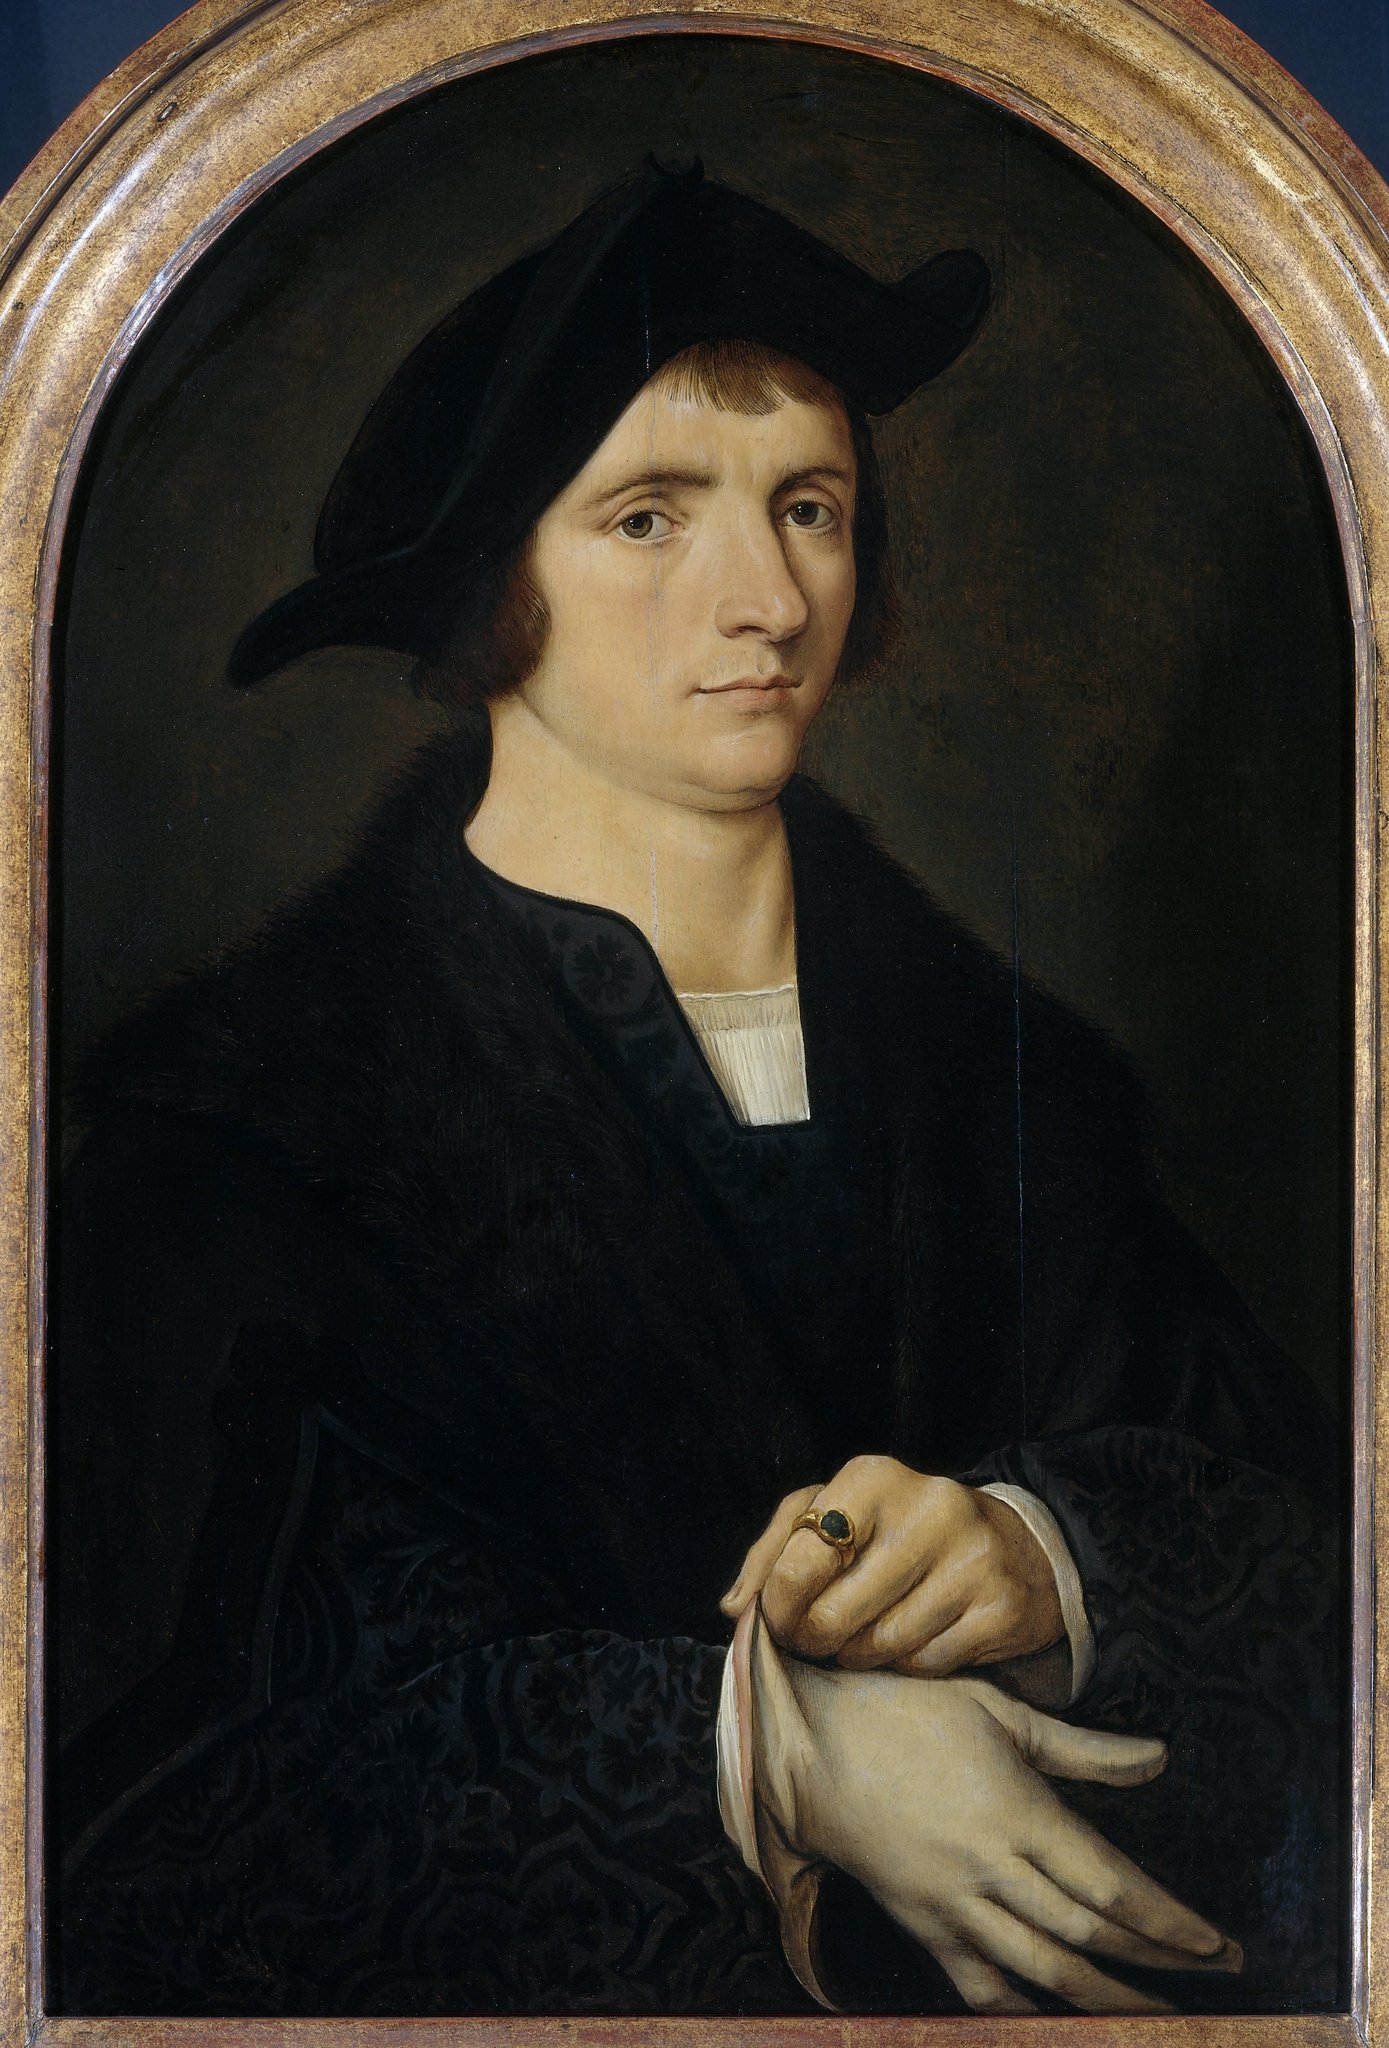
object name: painting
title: Joris W. Vezeler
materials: oil, panel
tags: den bosch, antwerp, goldsmith, mintmaster, historical persons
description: Portret van Joris W. Vezeler (Vezelaer) die een handschoen aantrekt.